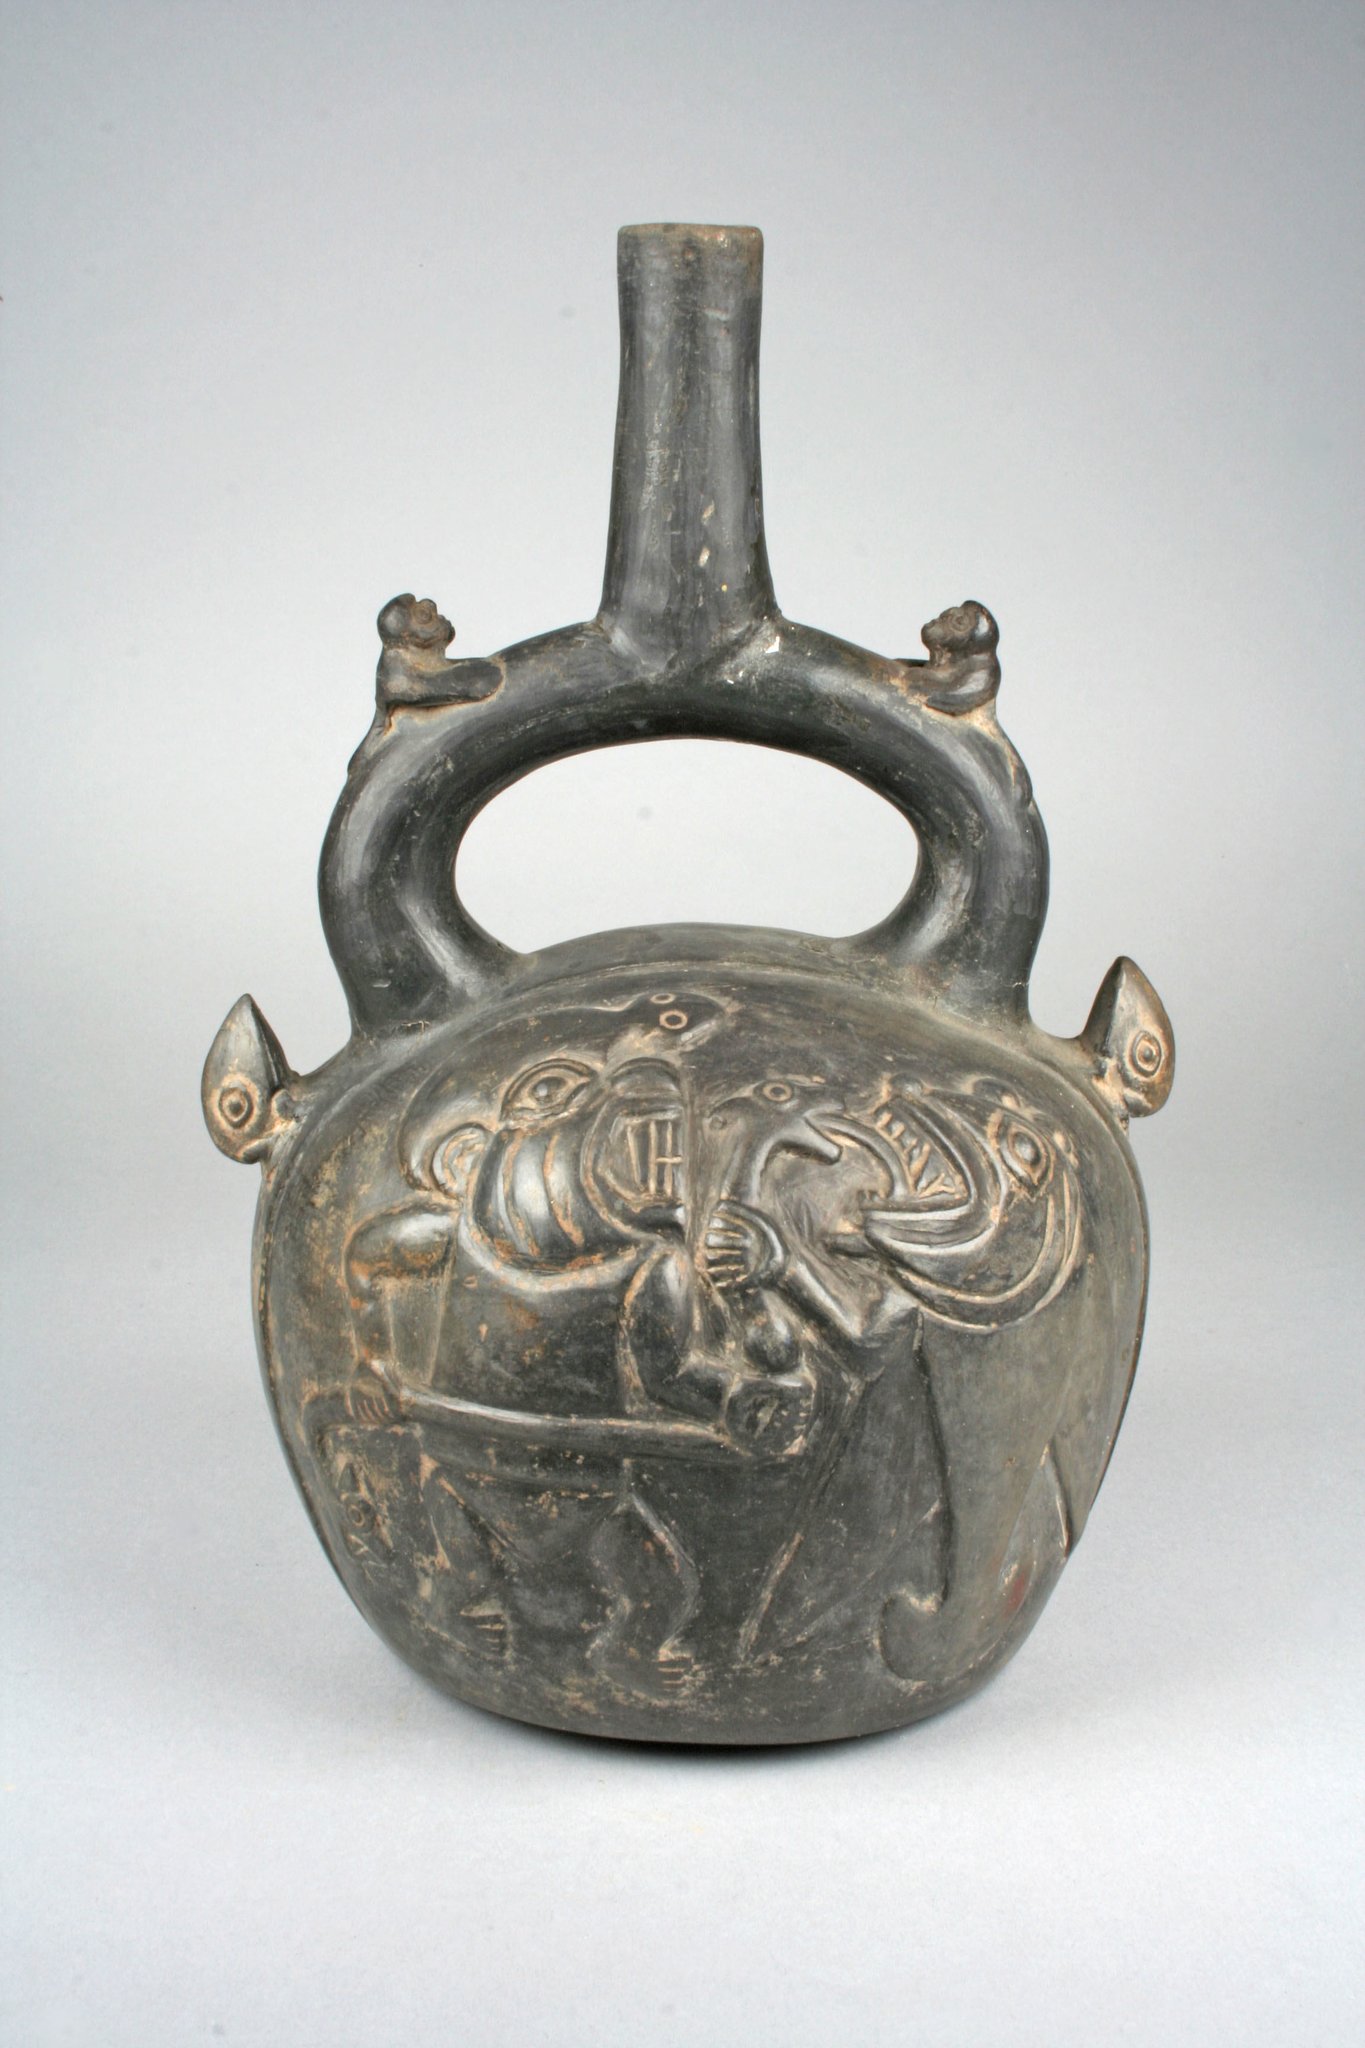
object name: bottle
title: Bottle, Fighting Figures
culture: chimú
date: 1101-1500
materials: ceramic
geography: peru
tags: mythical creatures